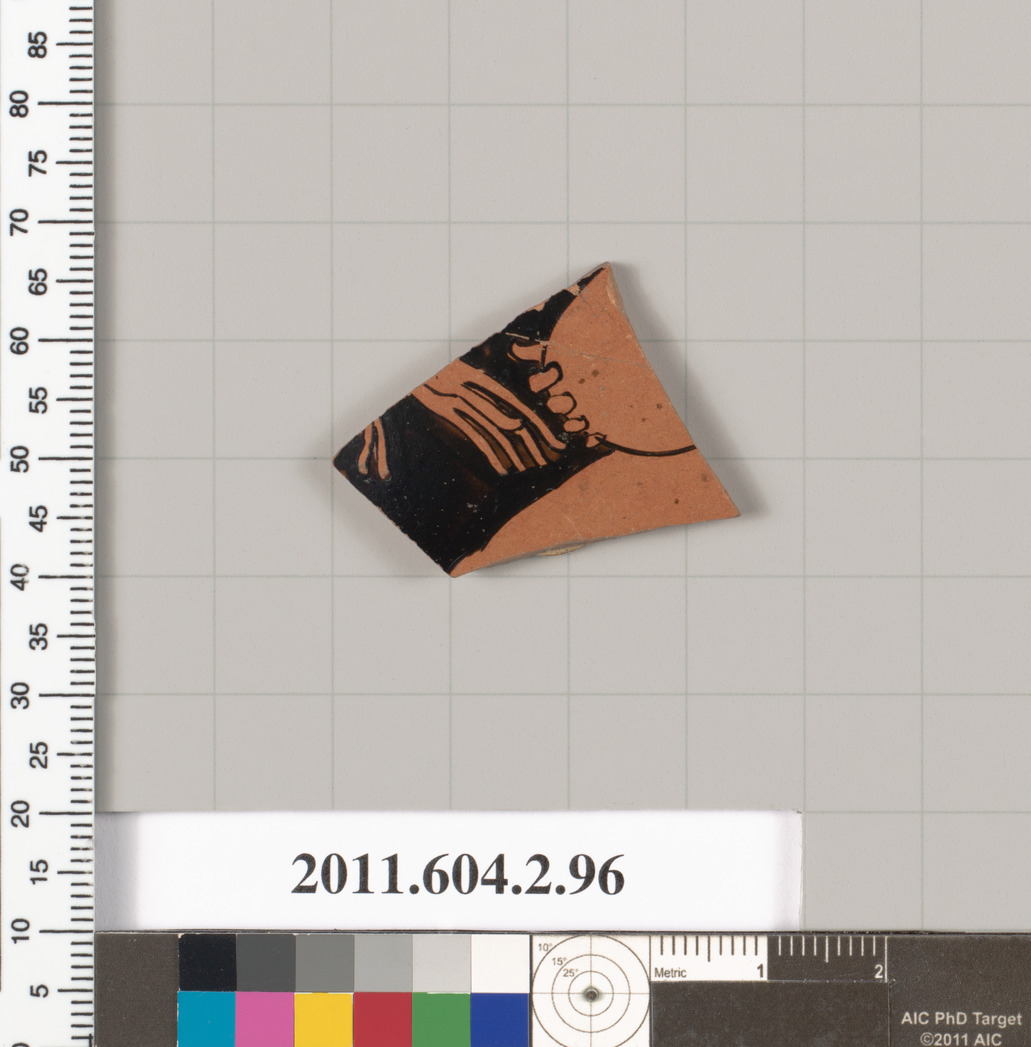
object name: pelike fragment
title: Terracotta fragment of a pelike (jar)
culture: greek, attic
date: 510-490 BCE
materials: terracotta